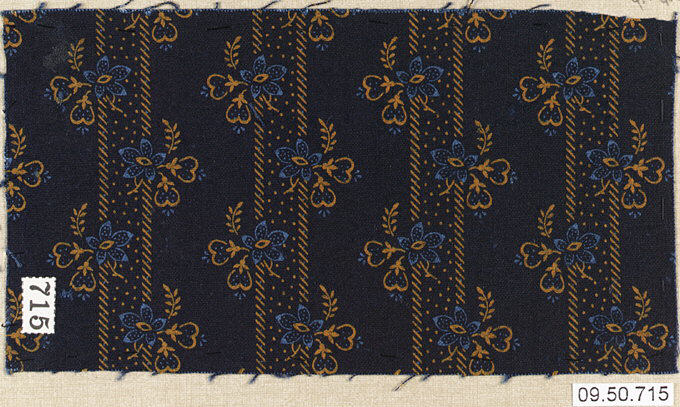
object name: piece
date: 1801-1900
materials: cotton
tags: flowers,leaves